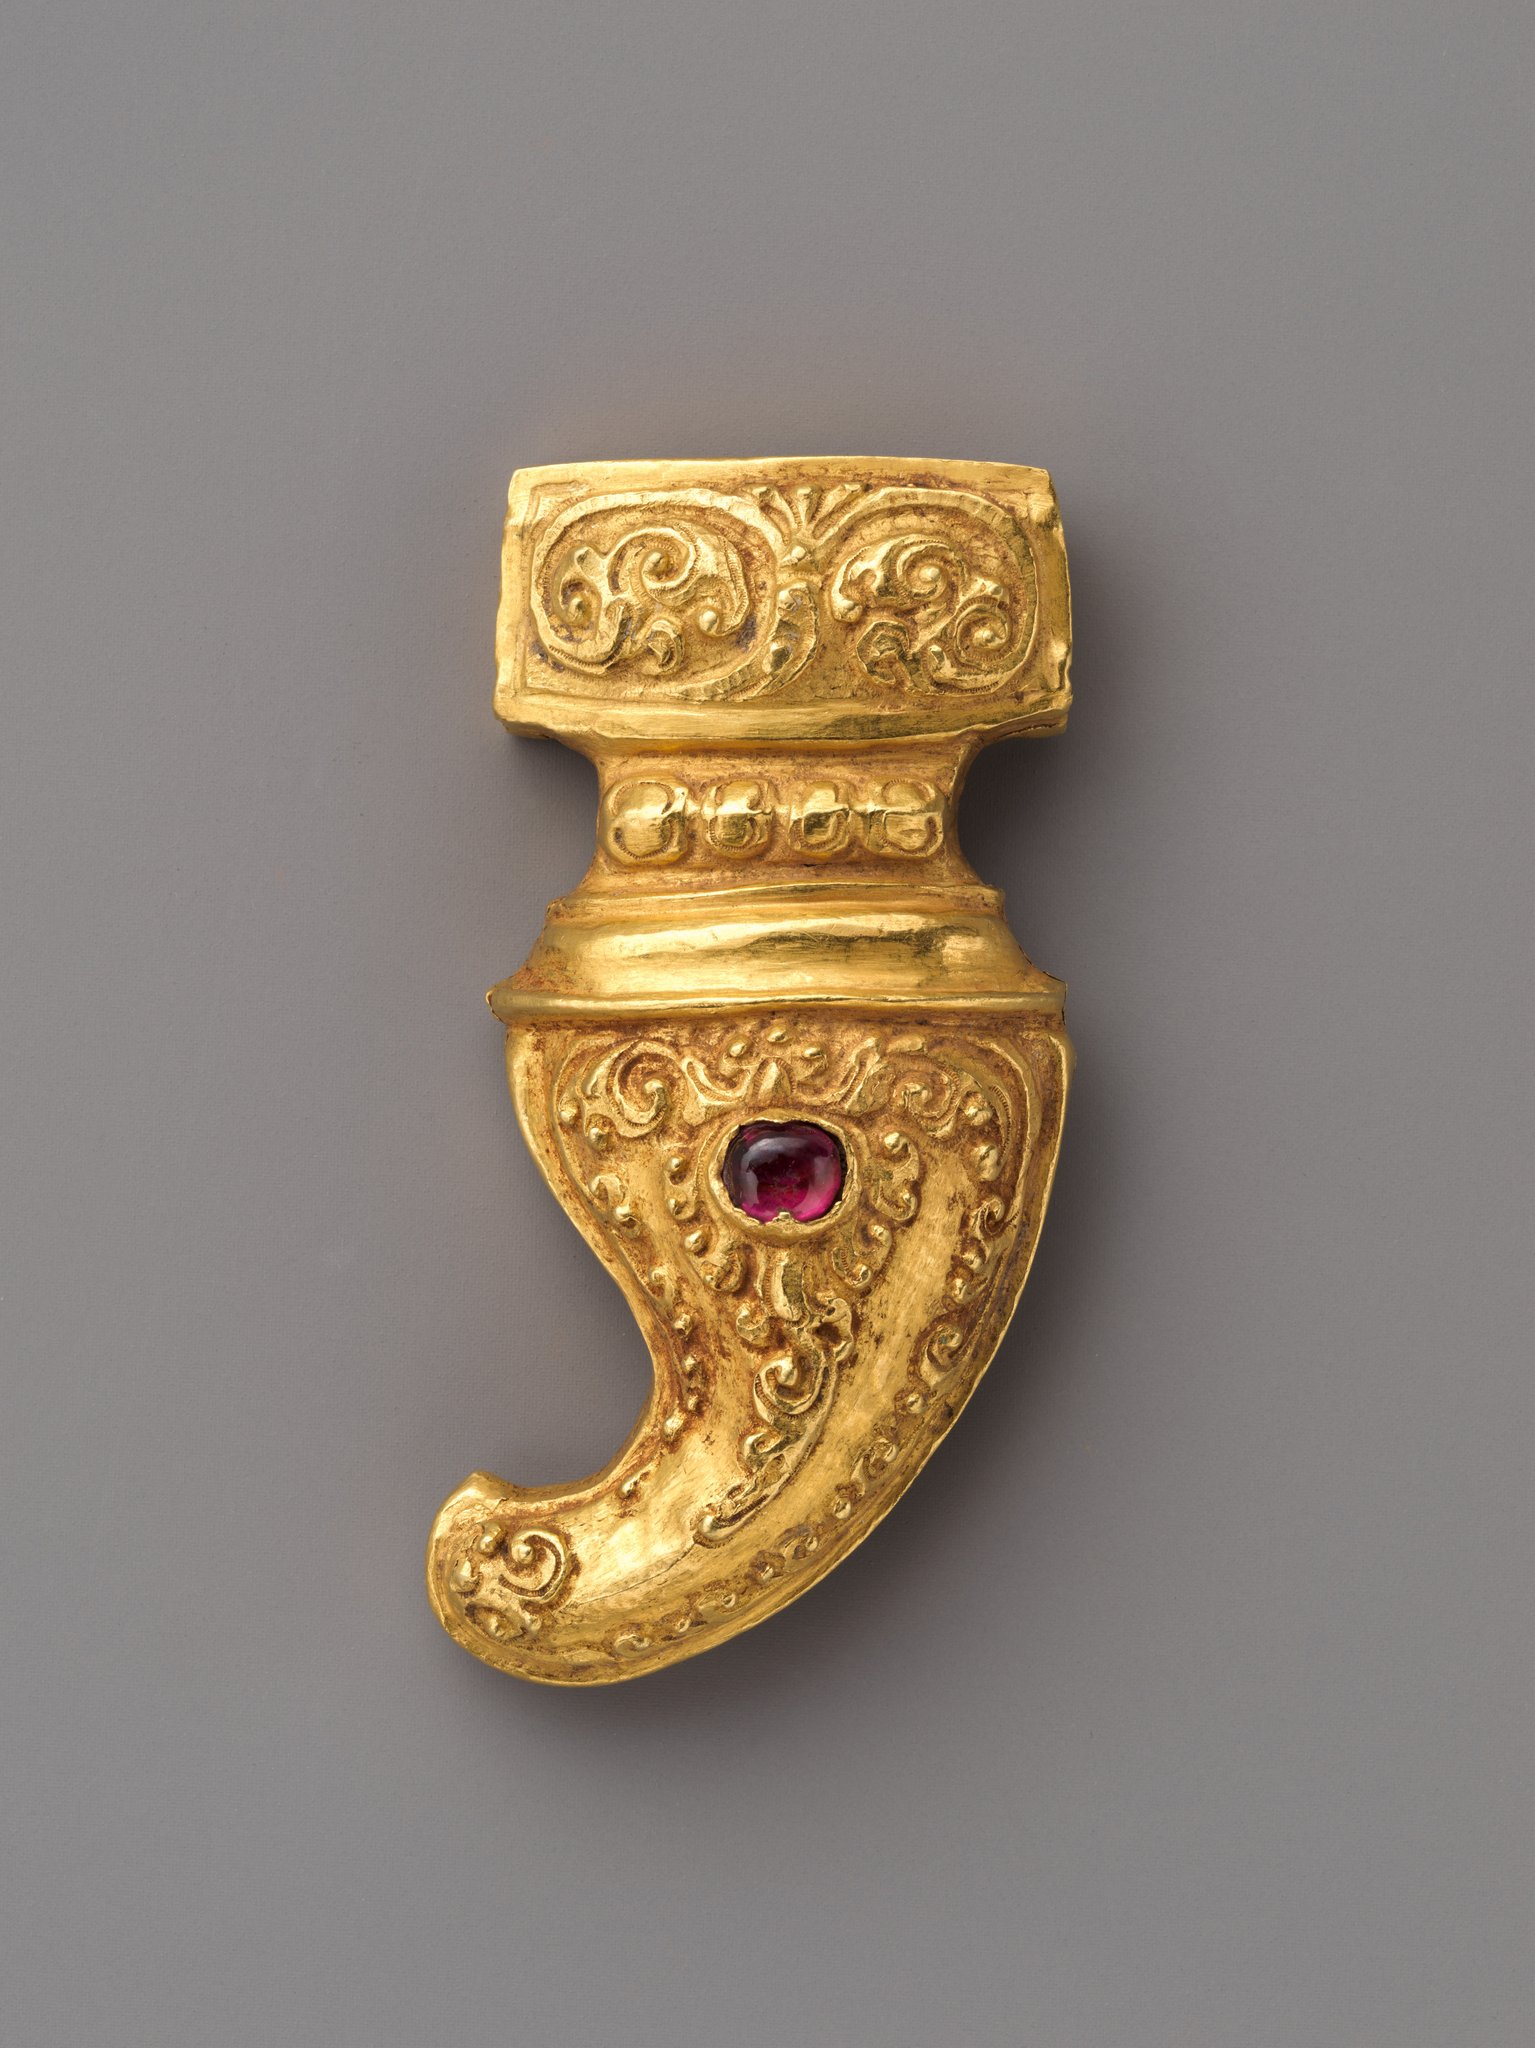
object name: pendant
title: Tiger Claw Pendant with Red Stone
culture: indonesian, central java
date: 701-1200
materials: gold